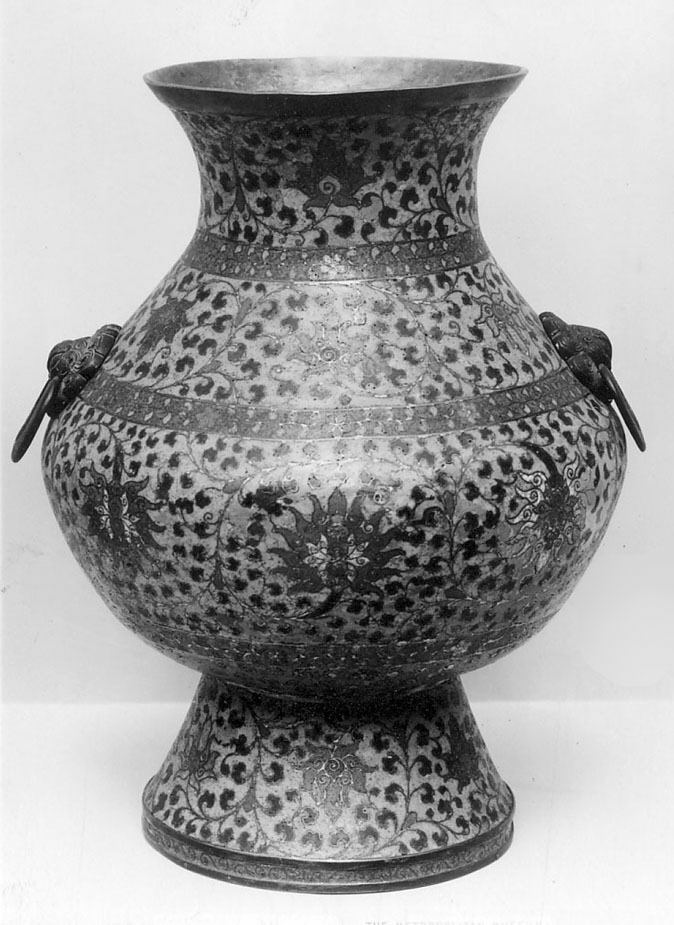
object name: vase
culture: chinese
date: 1368-1644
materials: copper, enamel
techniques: enamel